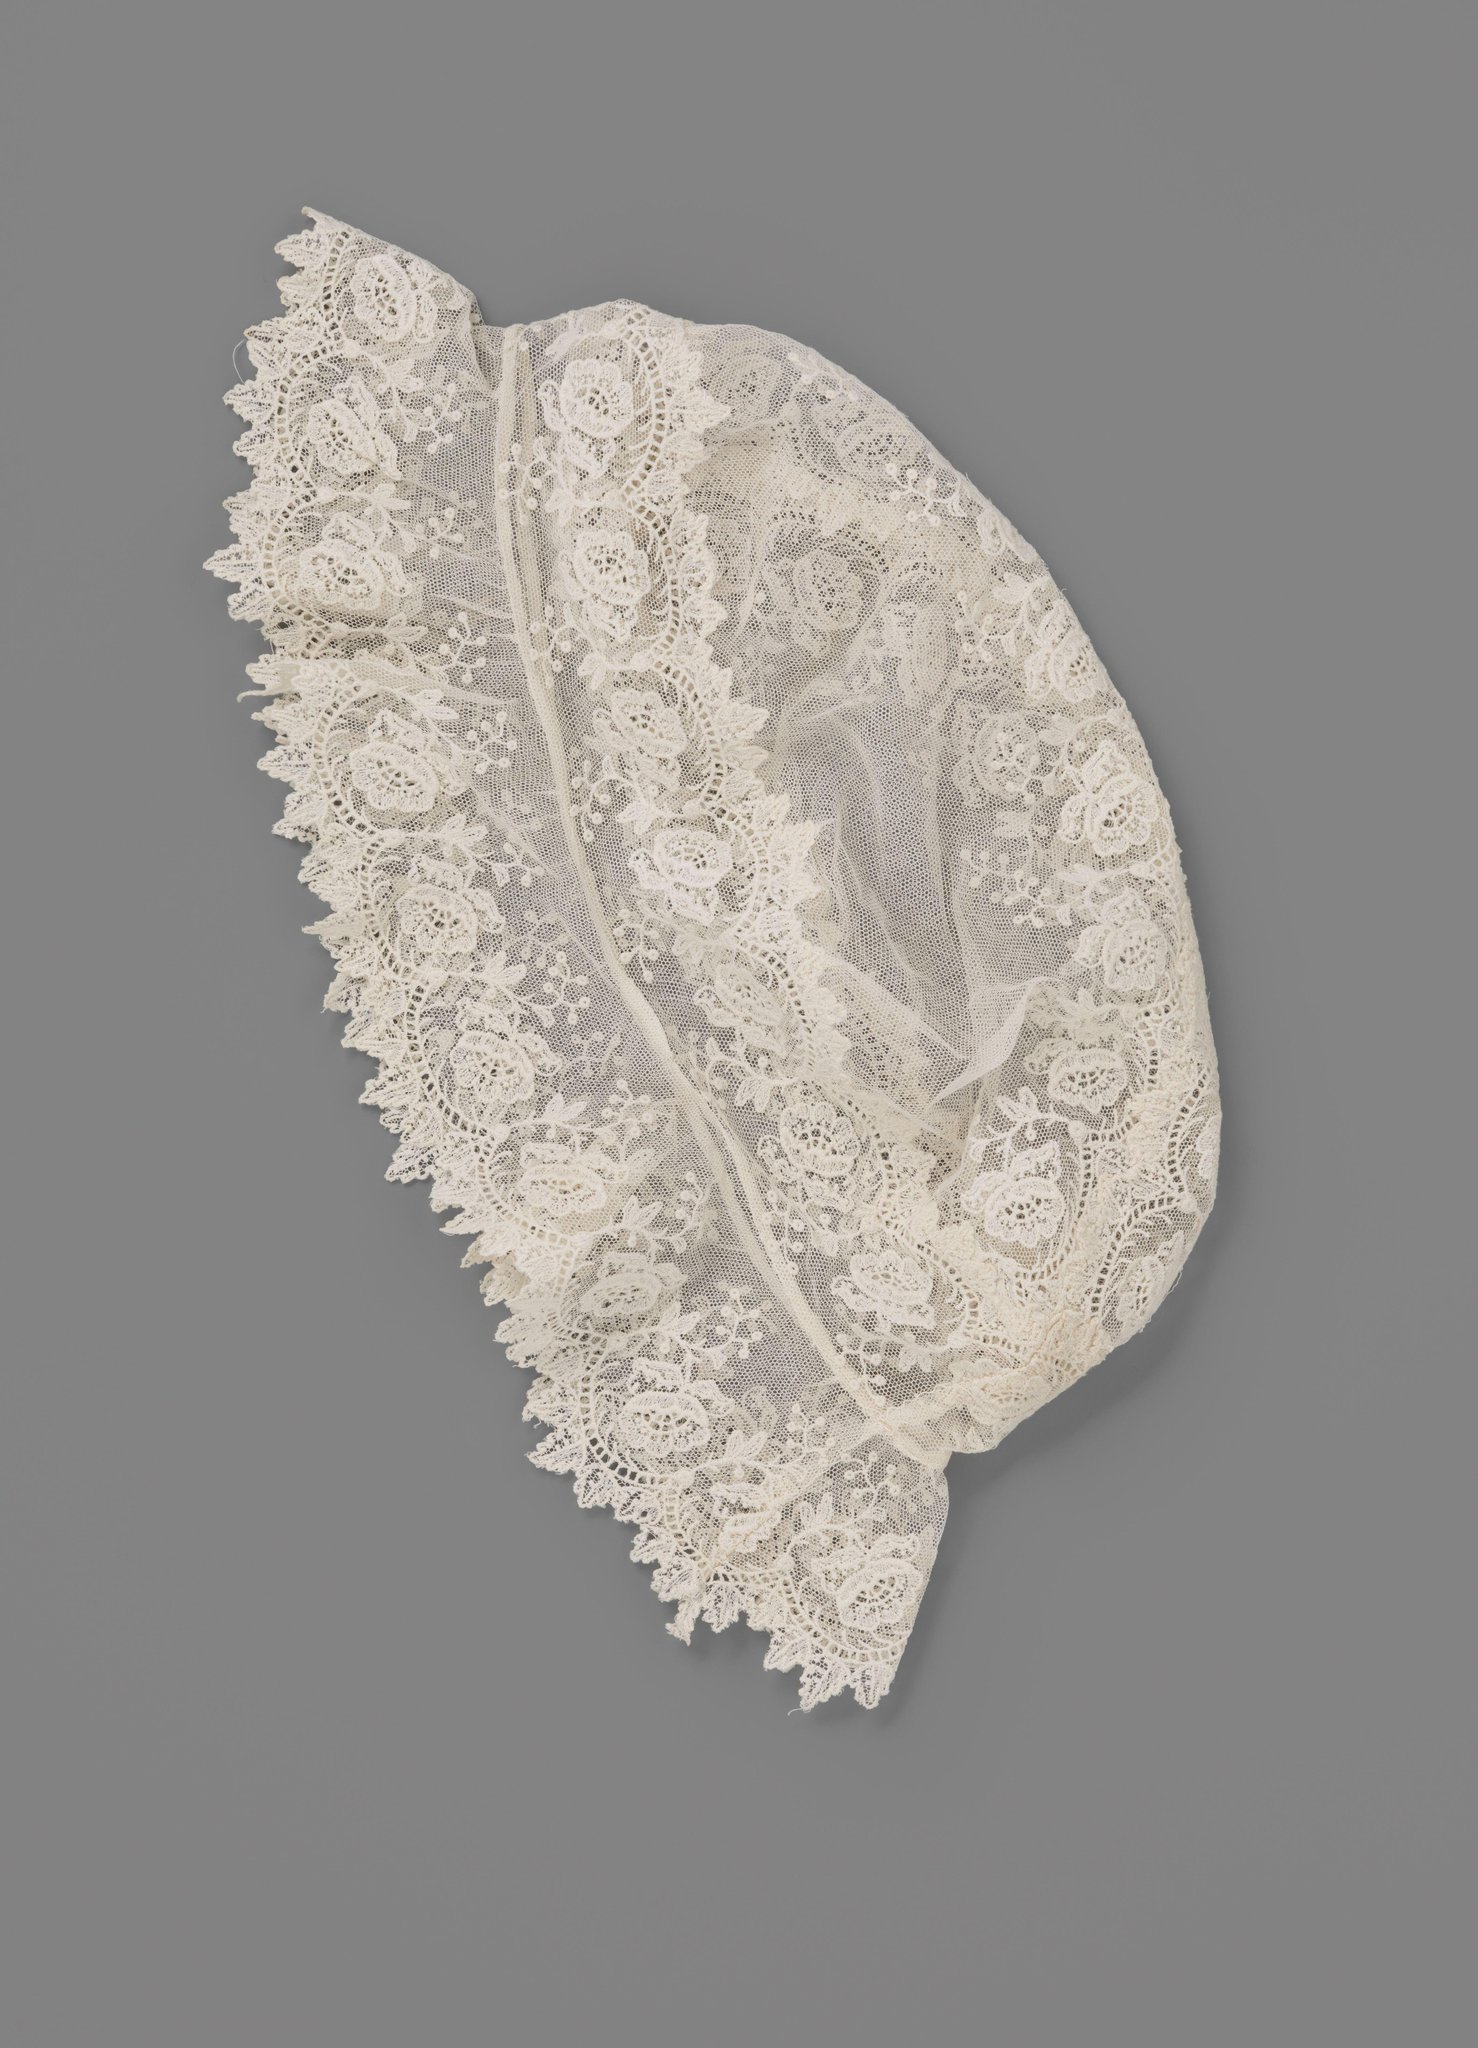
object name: womenswear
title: Négligé-muts van machinale kantstroken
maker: Anonymous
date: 1905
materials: lace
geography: france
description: Nègligè-muts van machinale kantstroken. Versiering: De bol is samengesteld uit twee brede knatstroken, waarvan de geschulpte zijden de hoofdnaad vormen. In de galdde hoofdband is de strook staande genomen, in de gerimpelde strook hangend. Het patroon is lopend en bestaat uit enkelvoudige roosjes per schulp, welke laatste is onderverdeed in scherpe puntjes, elk van bladjes gevormd.